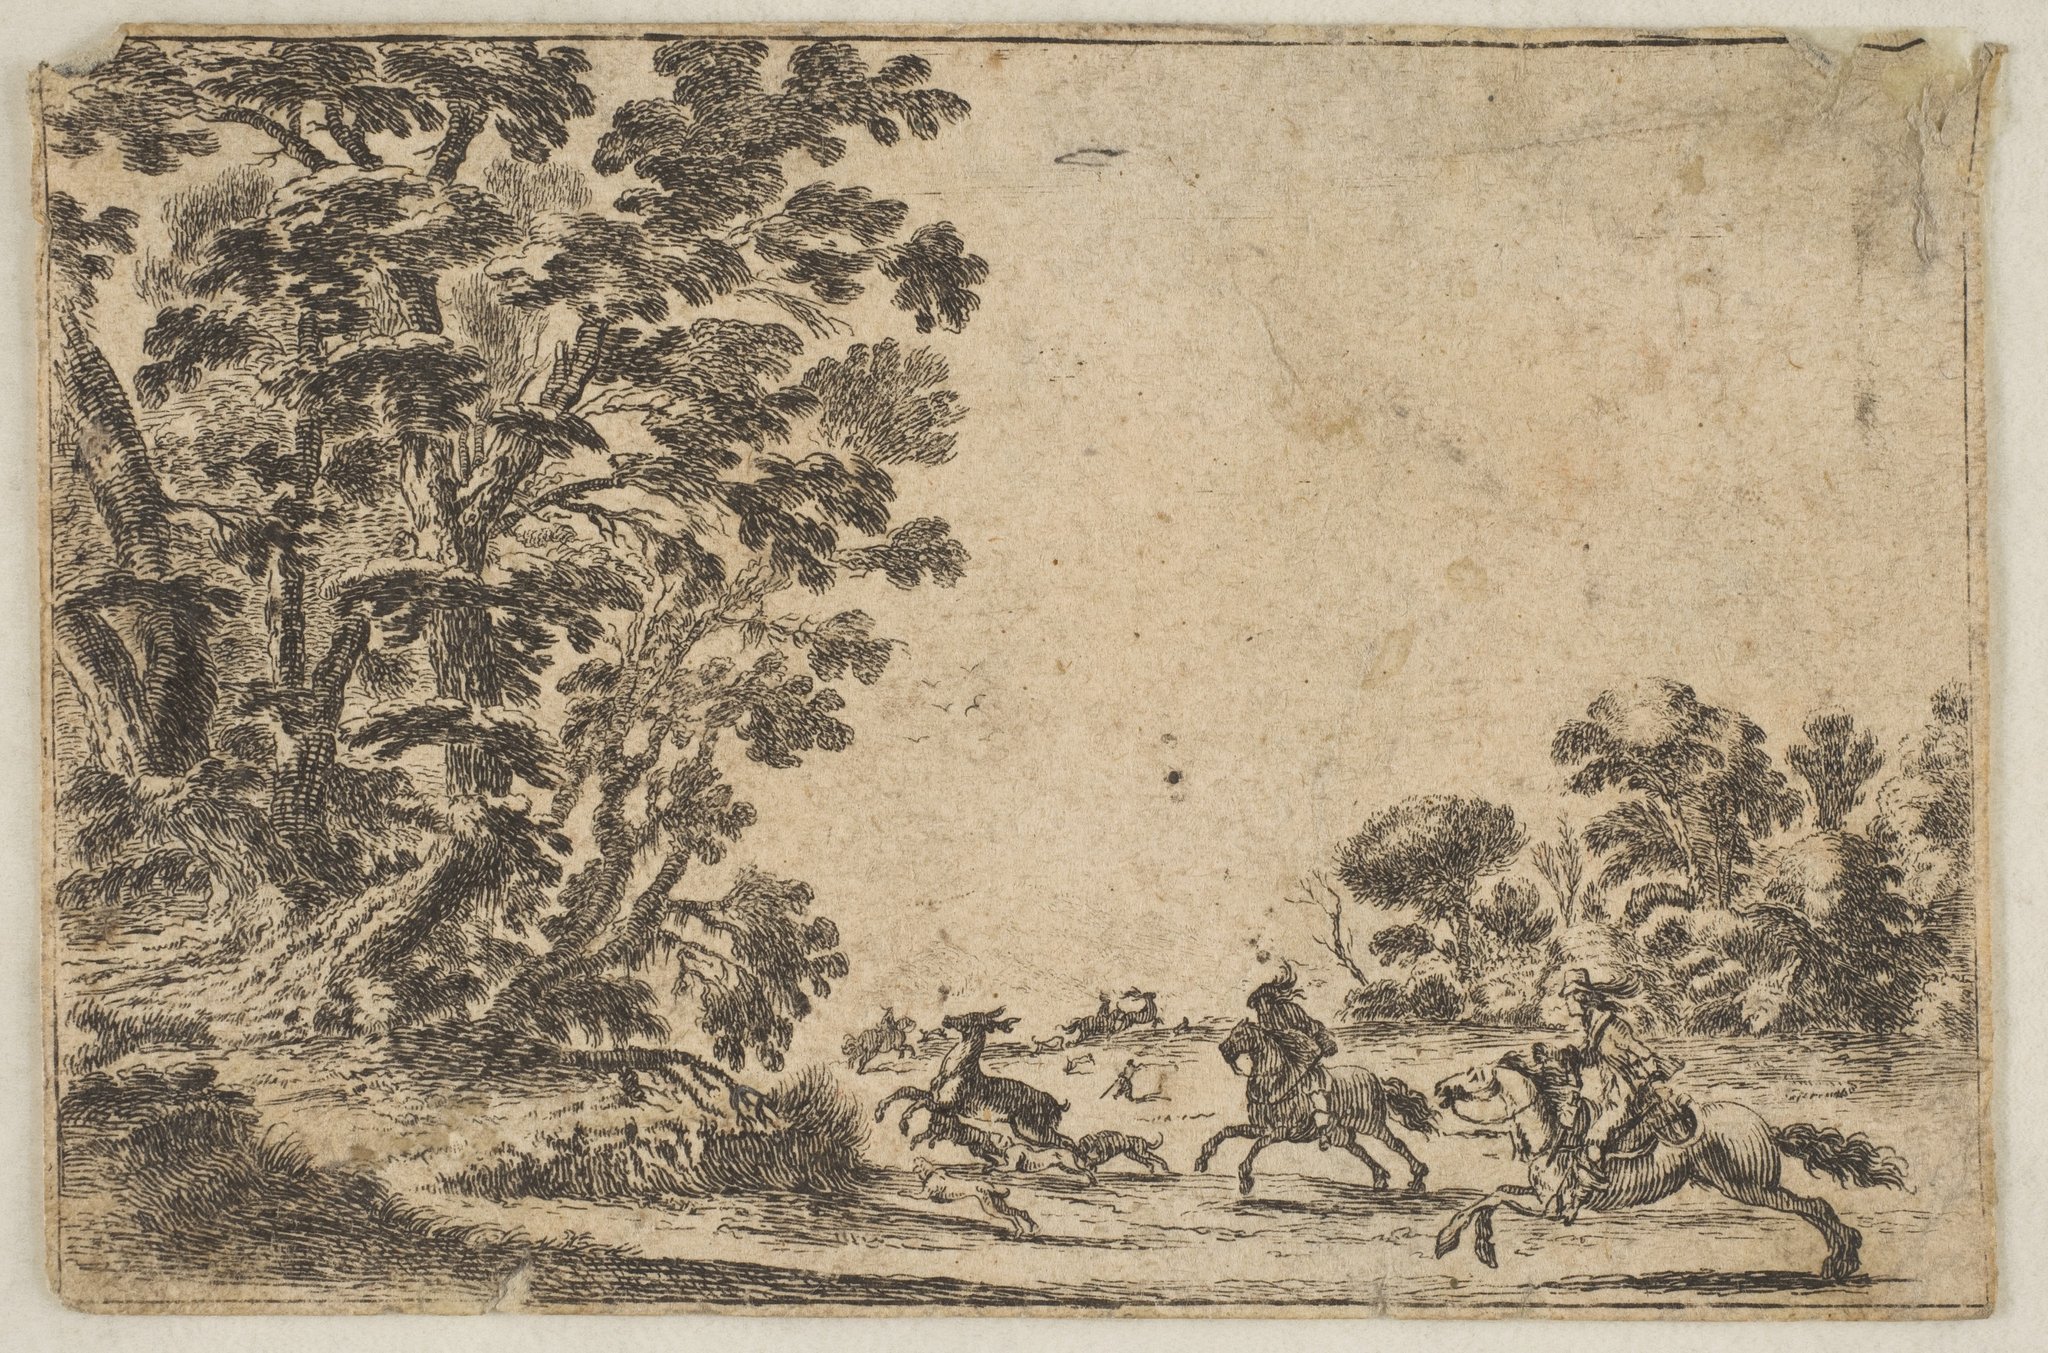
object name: print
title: Plate 4: a deer hunt, two horsemen galloping towards the rightbehind three dogs and a deer, a group of trees to left, from "Various Figures" (Agréable diversité de figures)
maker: stefano della bella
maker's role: artist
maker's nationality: italian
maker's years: 1610-1664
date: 1642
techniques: etching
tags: human figures,hunting,deer,horses,trees